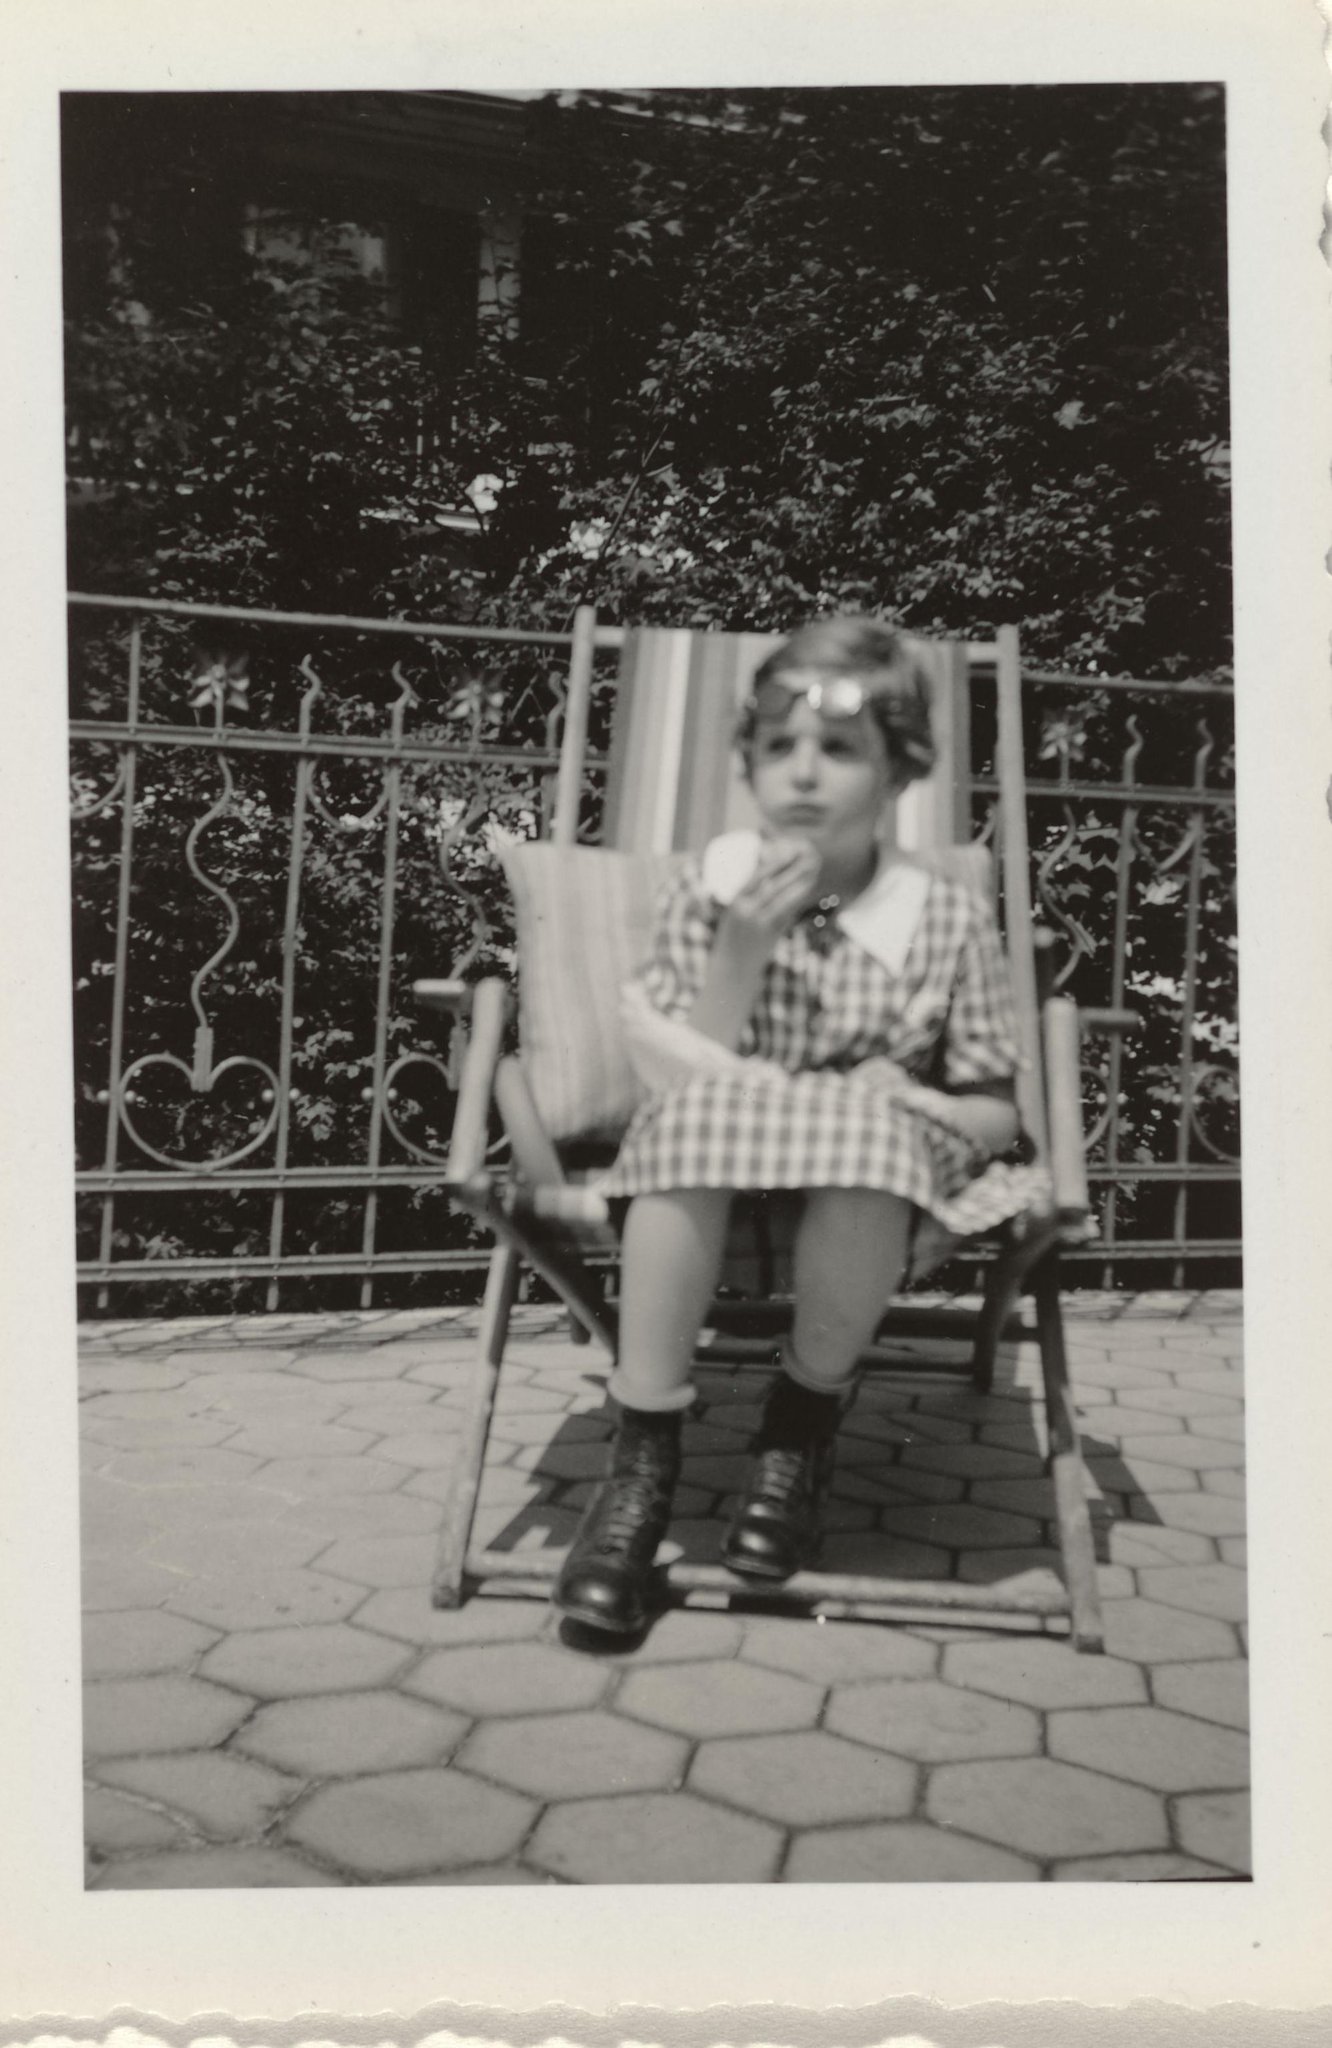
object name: photograph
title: Isabel Wachenheimer eet een perzik op een ligstoel op een terras in Engelberg, augustus 1935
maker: Anonymous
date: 1908-1935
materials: photographic support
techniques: gelatin silver print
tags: leiden, isabel wachenheimer-elon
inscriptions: inscription: ‘Aug.35. Isabel, einen Pfirsch verzeh // rend’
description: Isabel Wachenheimer eet een perzik op een ligstoel op een terras in Engelberg.